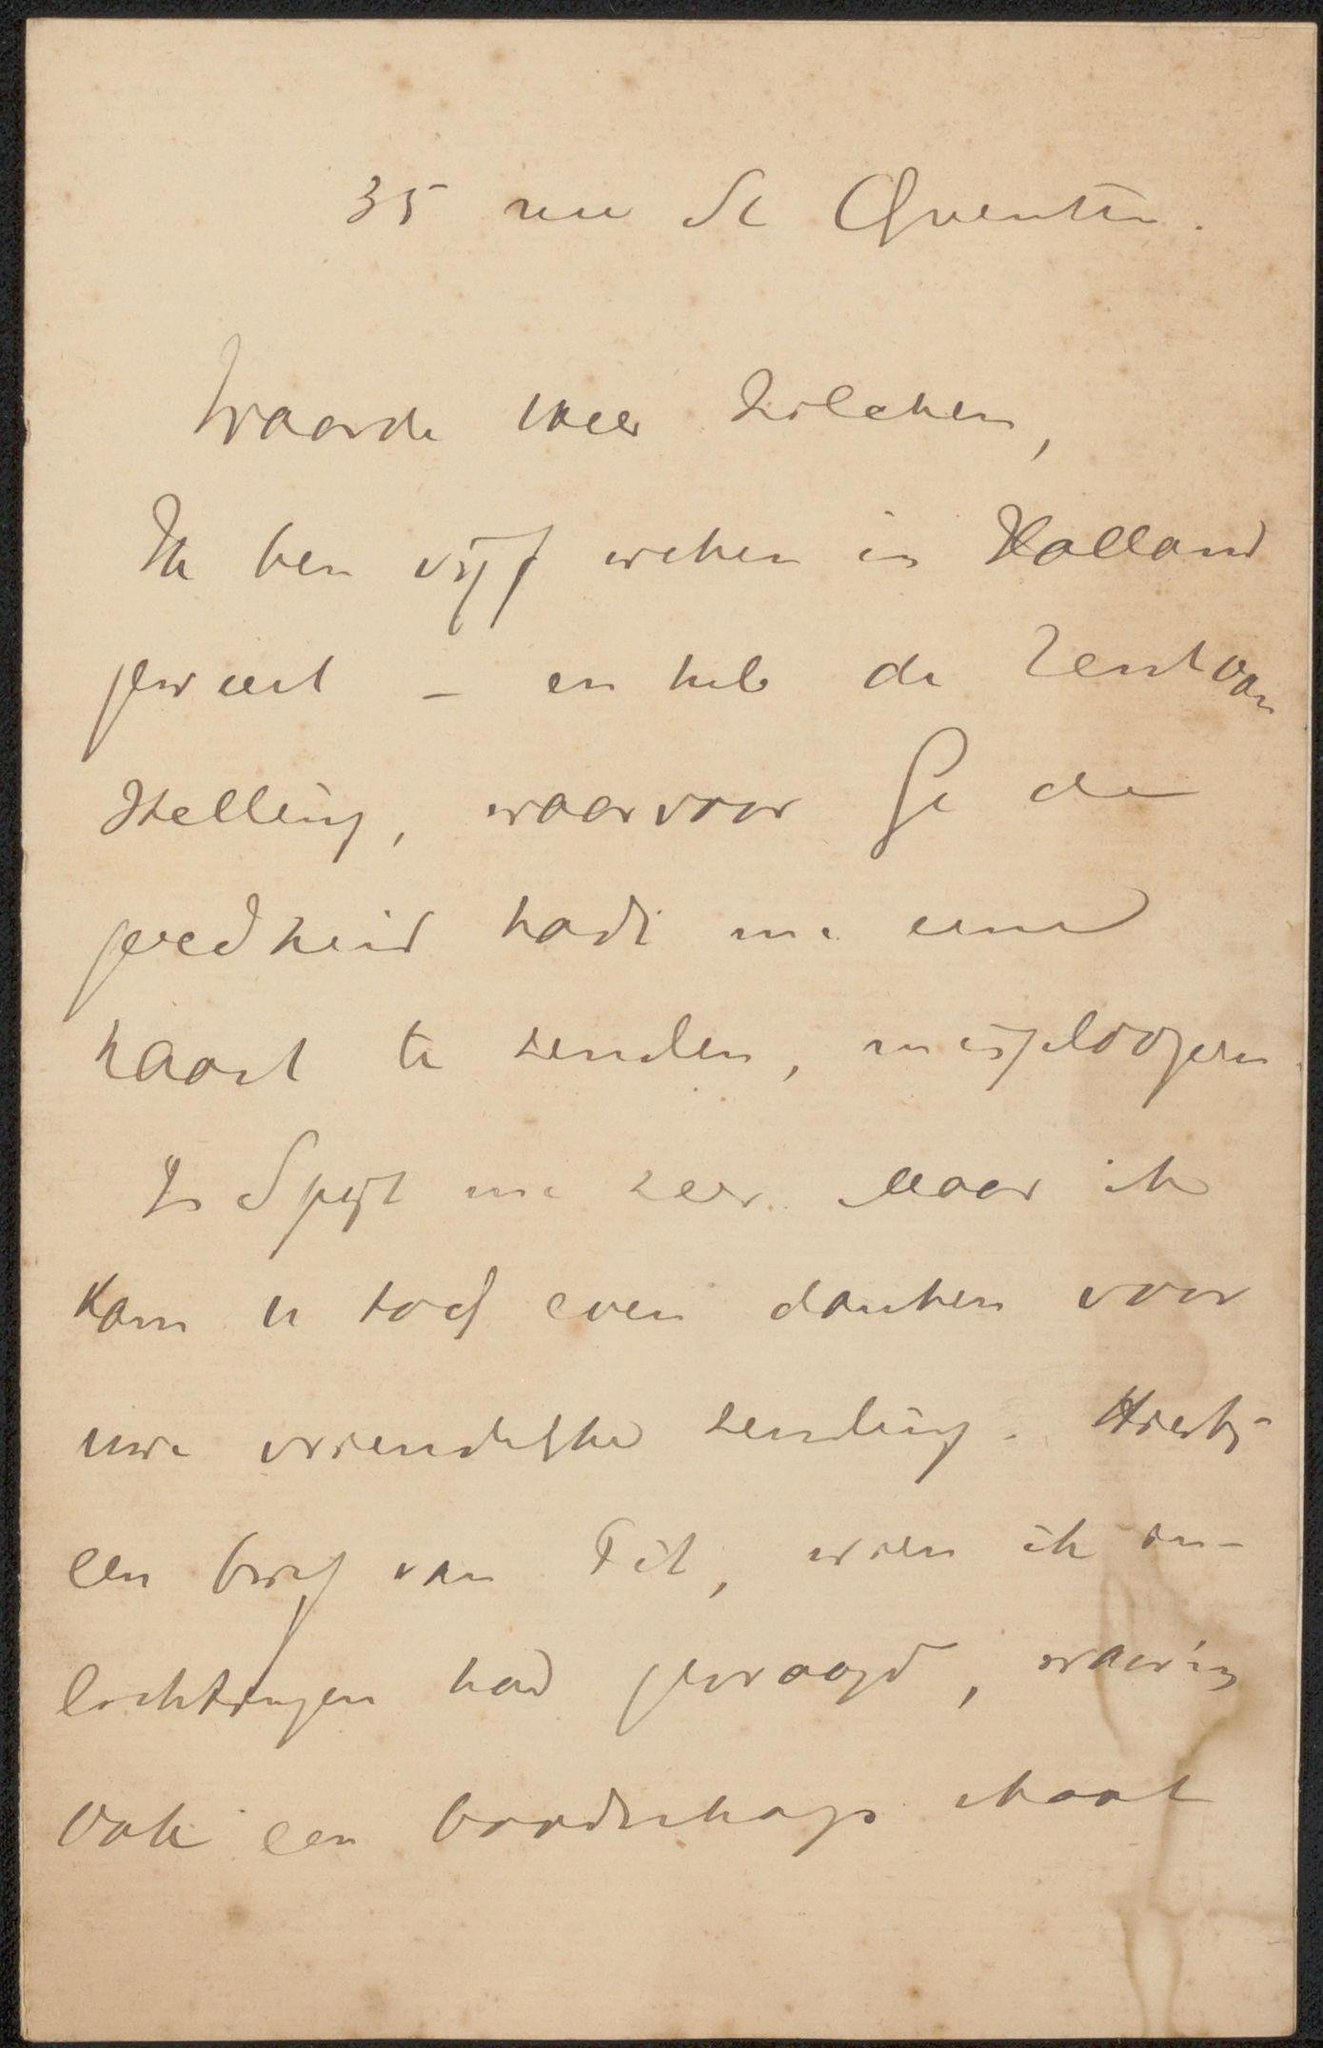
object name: letter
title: Brief aan Philip Zilcken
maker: johan de meester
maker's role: schrijver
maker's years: 1860-1931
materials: ink, paper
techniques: pen, writing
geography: rotterdam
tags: the hague, nijmegen, print maker, adriaan pit, painter, philip zilcken, exhibition ~ art, holland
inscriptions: collector's mark: ‘RPK’